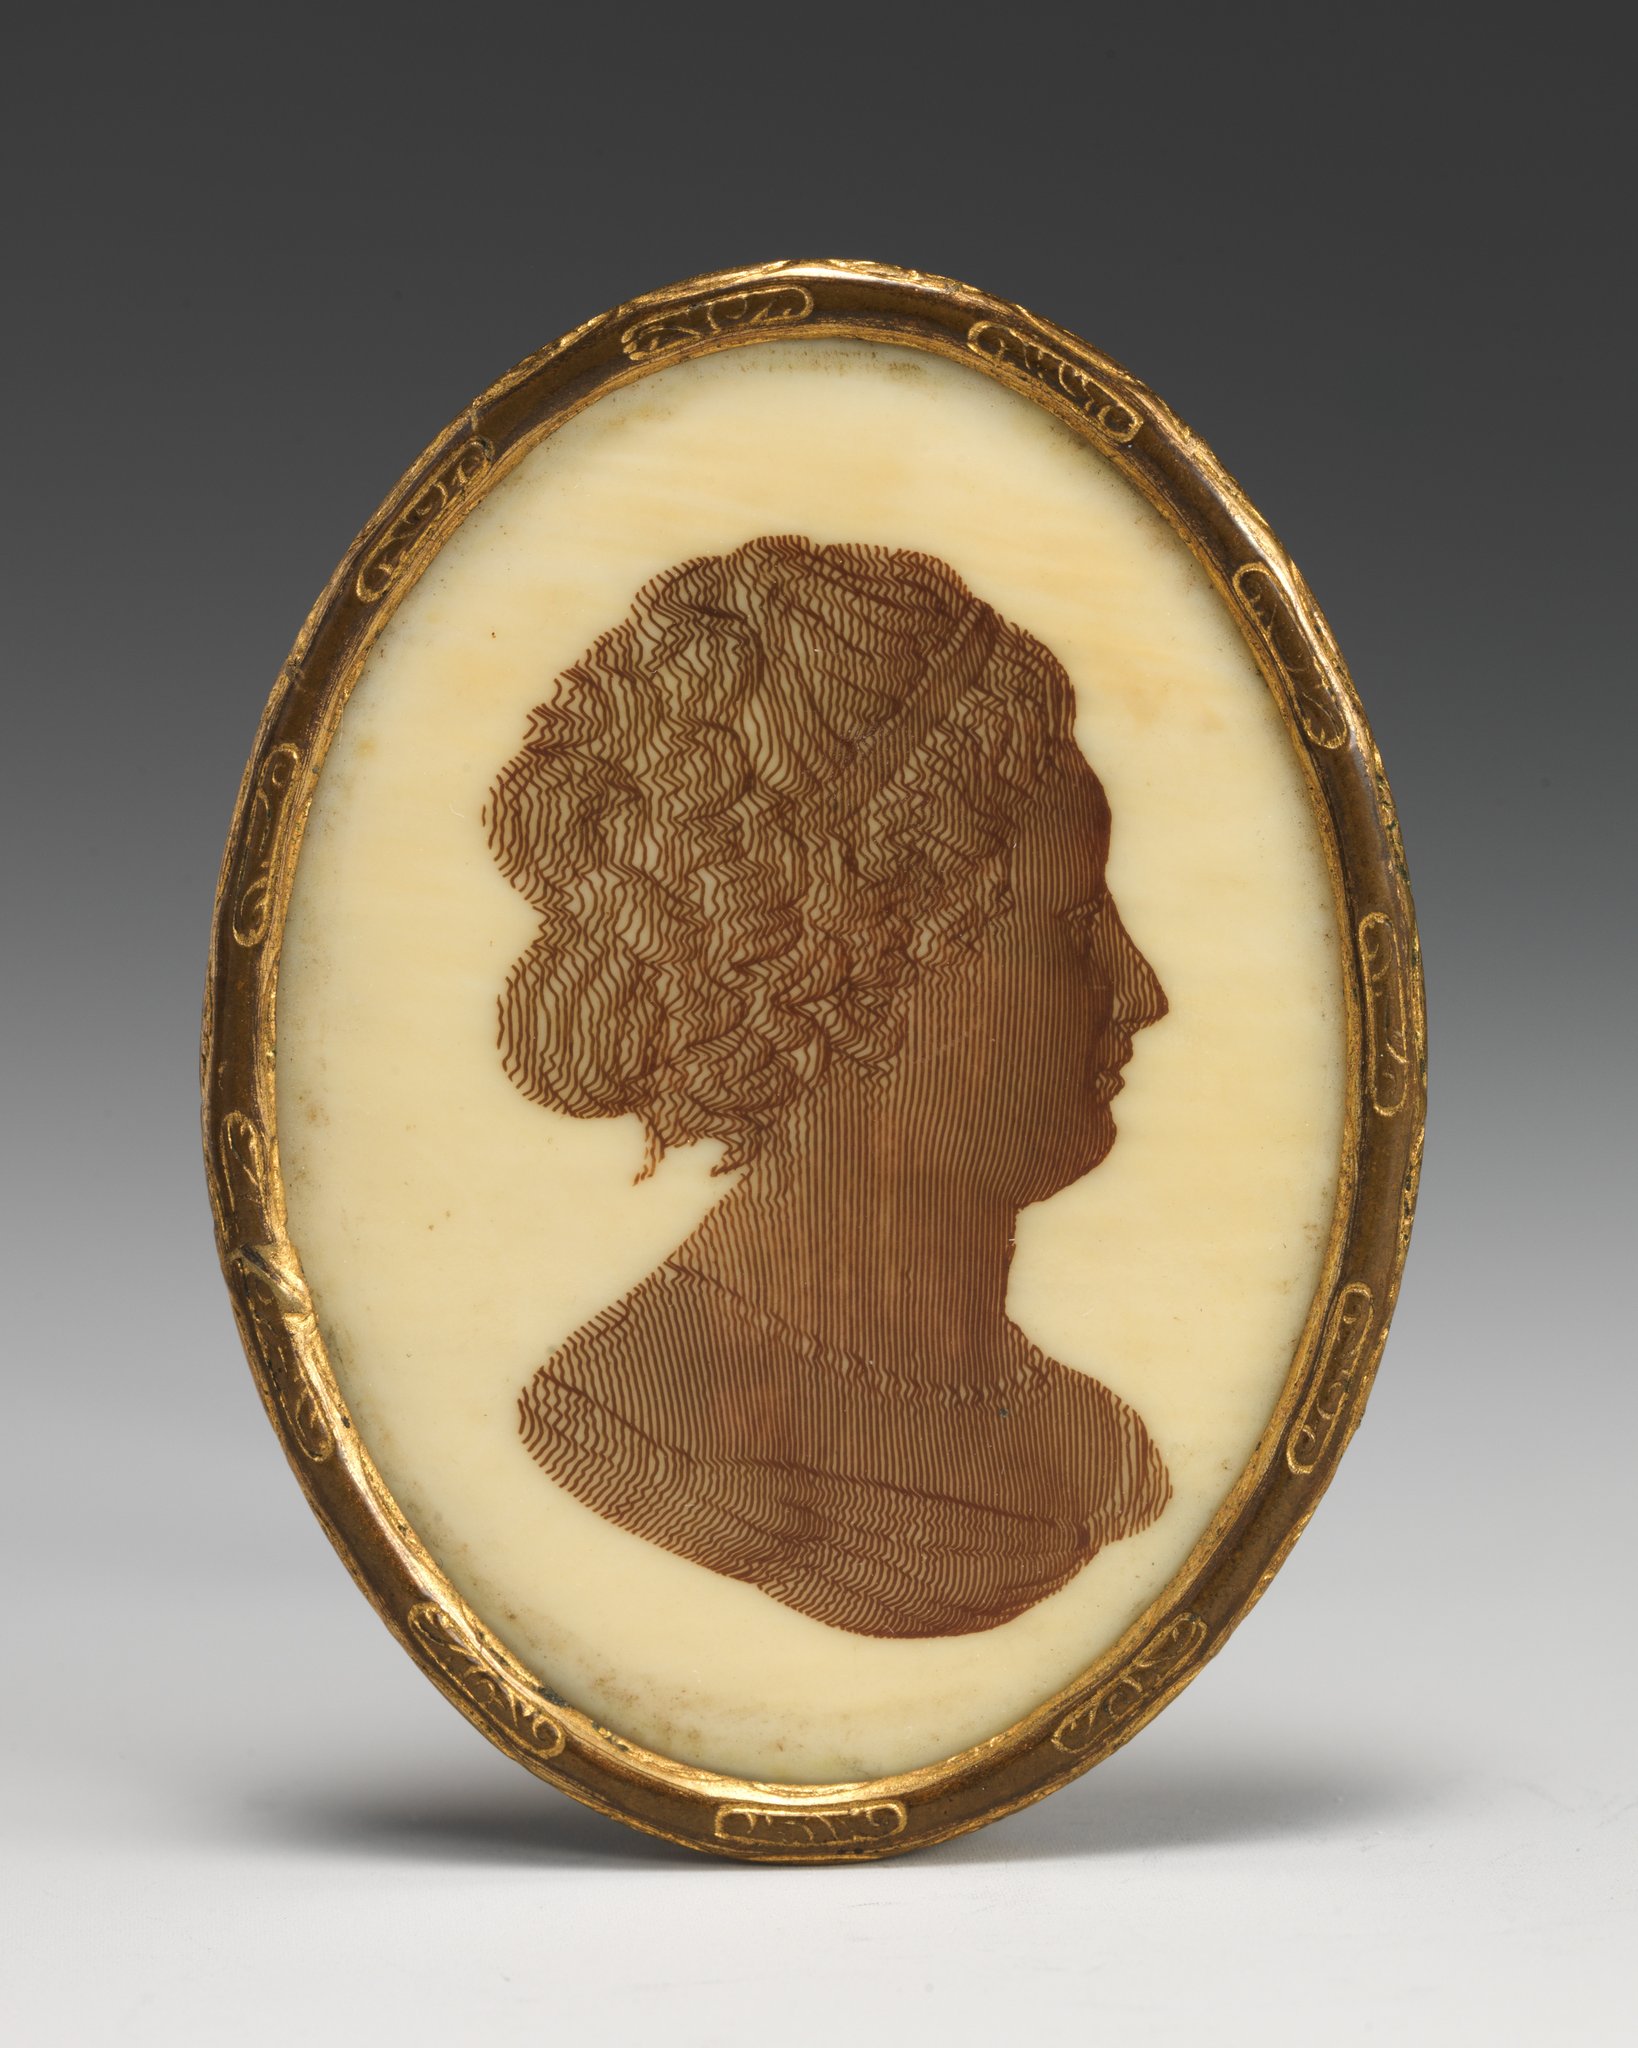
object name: medallion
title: Head of a woman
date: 1801-1900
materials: brass, ivory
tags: profiles,women